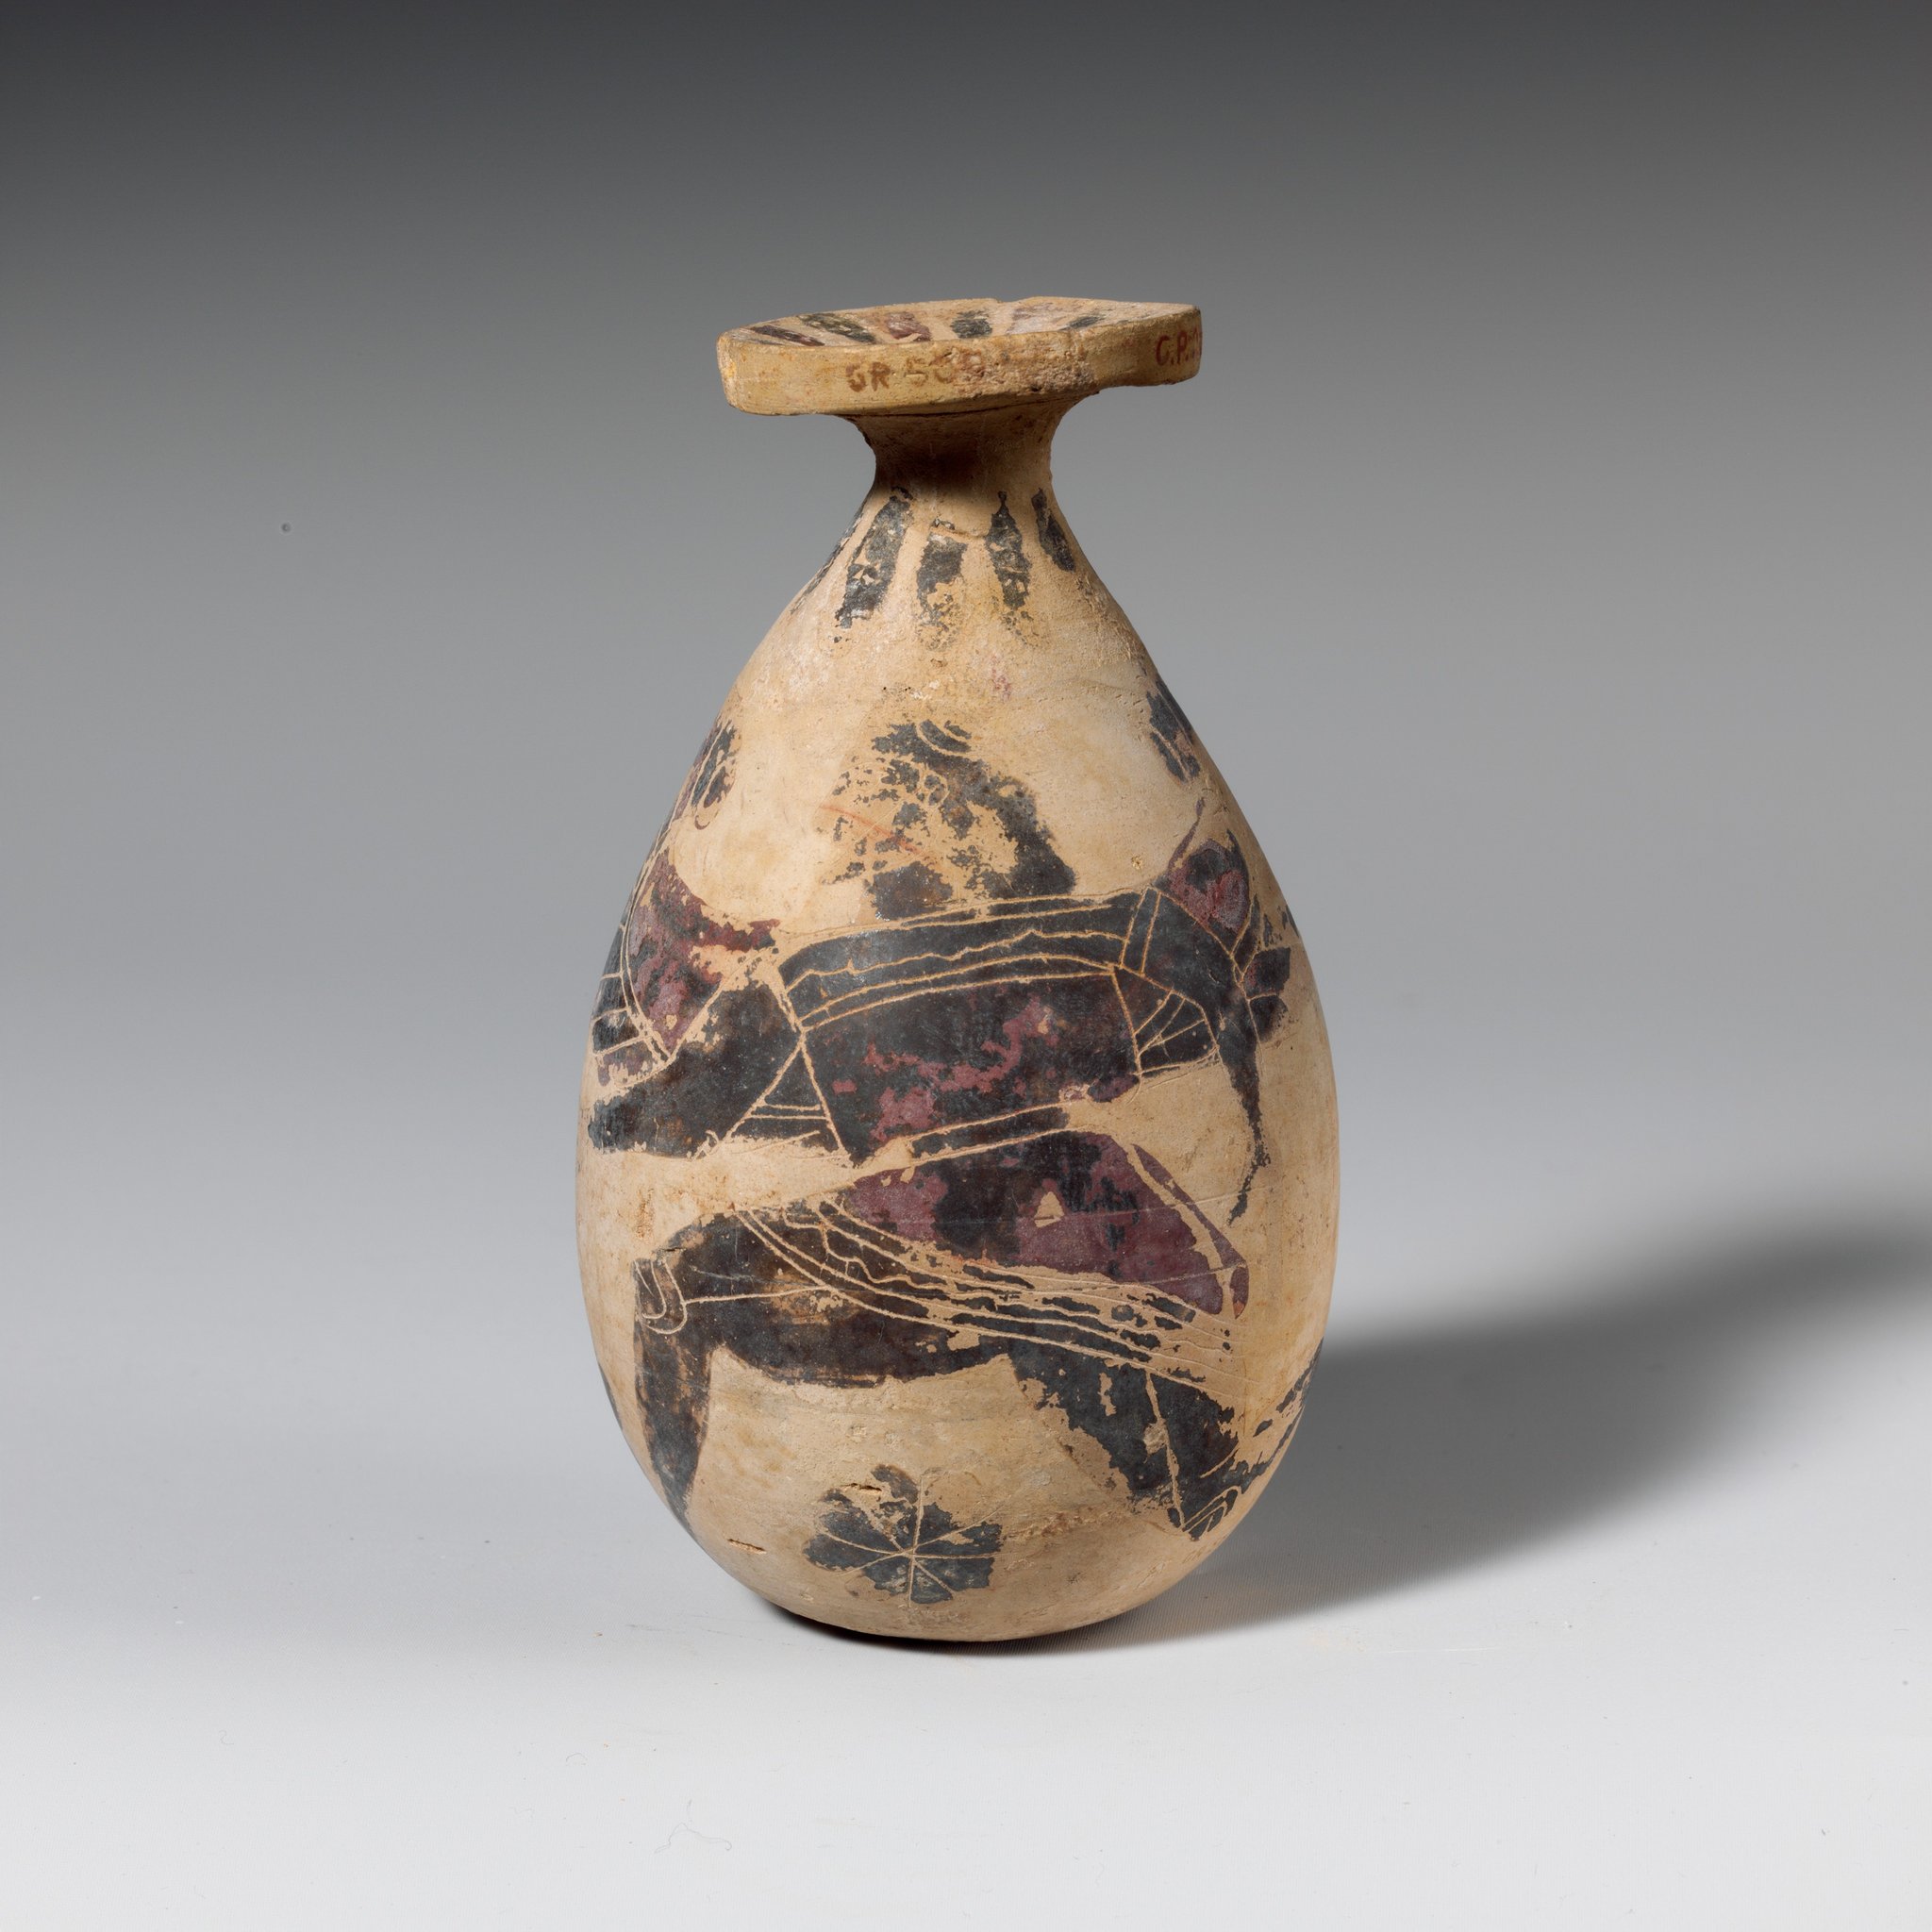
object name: alabastron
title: Terracotta alabastron (perfume vase)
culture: greek, corinthian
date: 630-615 BCE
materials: terracotta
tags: men